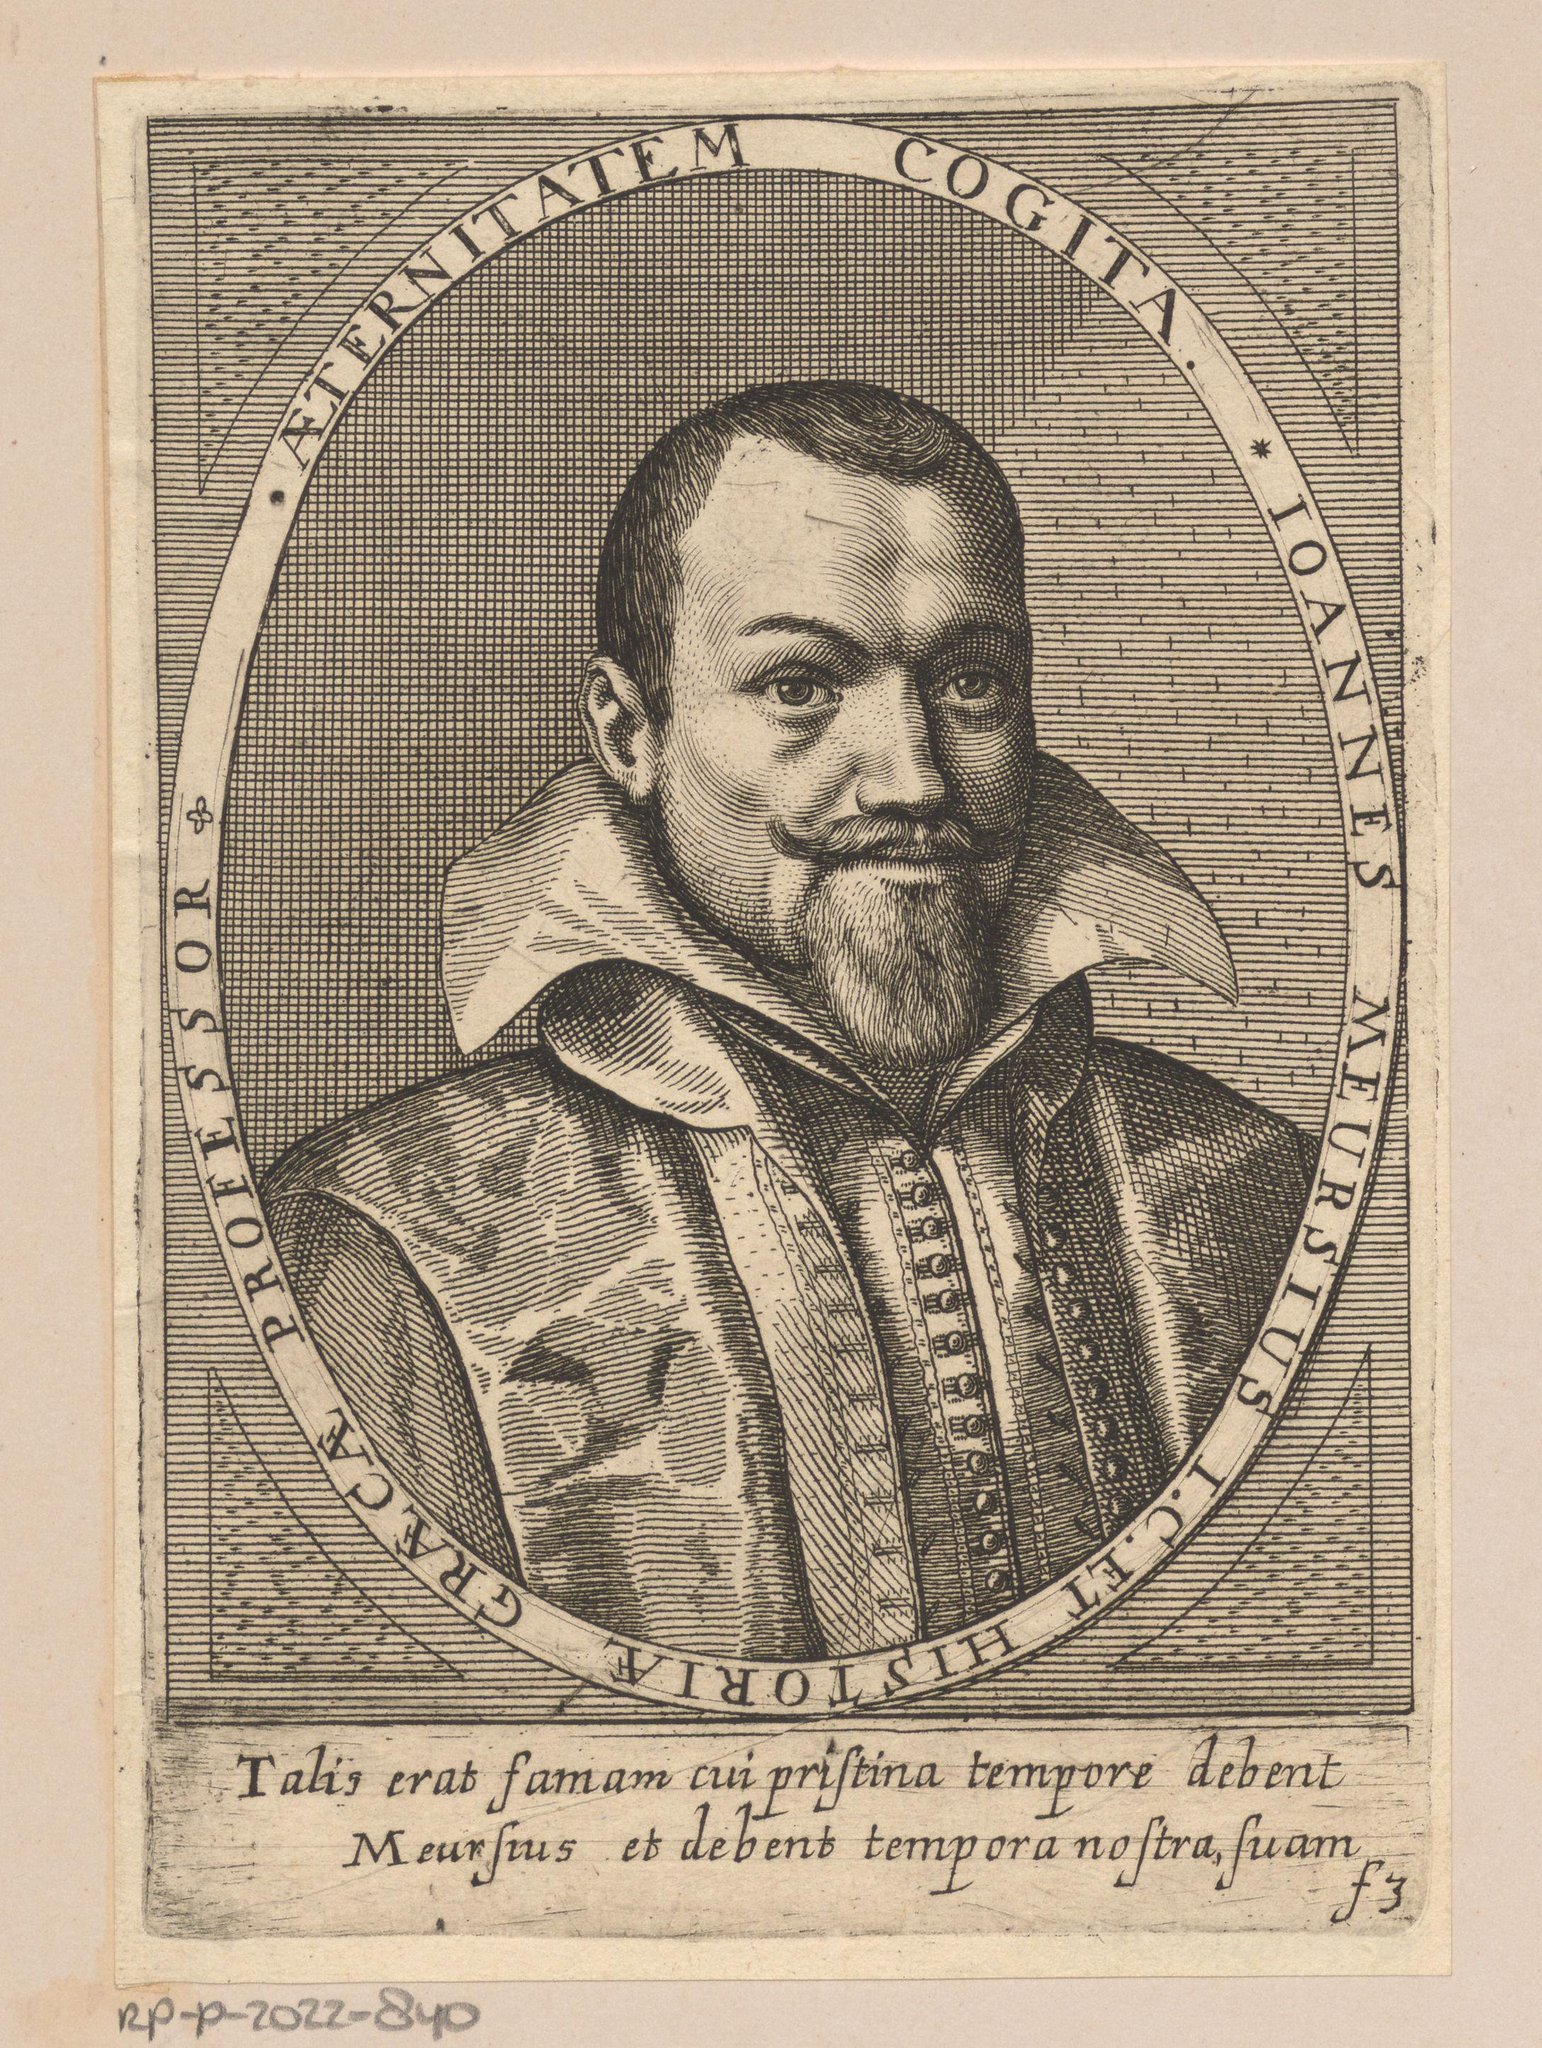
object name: print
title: Portret van Johannes Meursius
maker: Anonymous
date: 1650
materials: paper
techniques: engraving, etching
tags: historical persons, professor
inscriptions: number: ‘1863’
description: Prent waarschijnlijk uit: Boissard, Jean Jacques. Bibliotheca chalcographica (...) VI pars. Frankfurt am Main: Johannes Ammon, 1650.